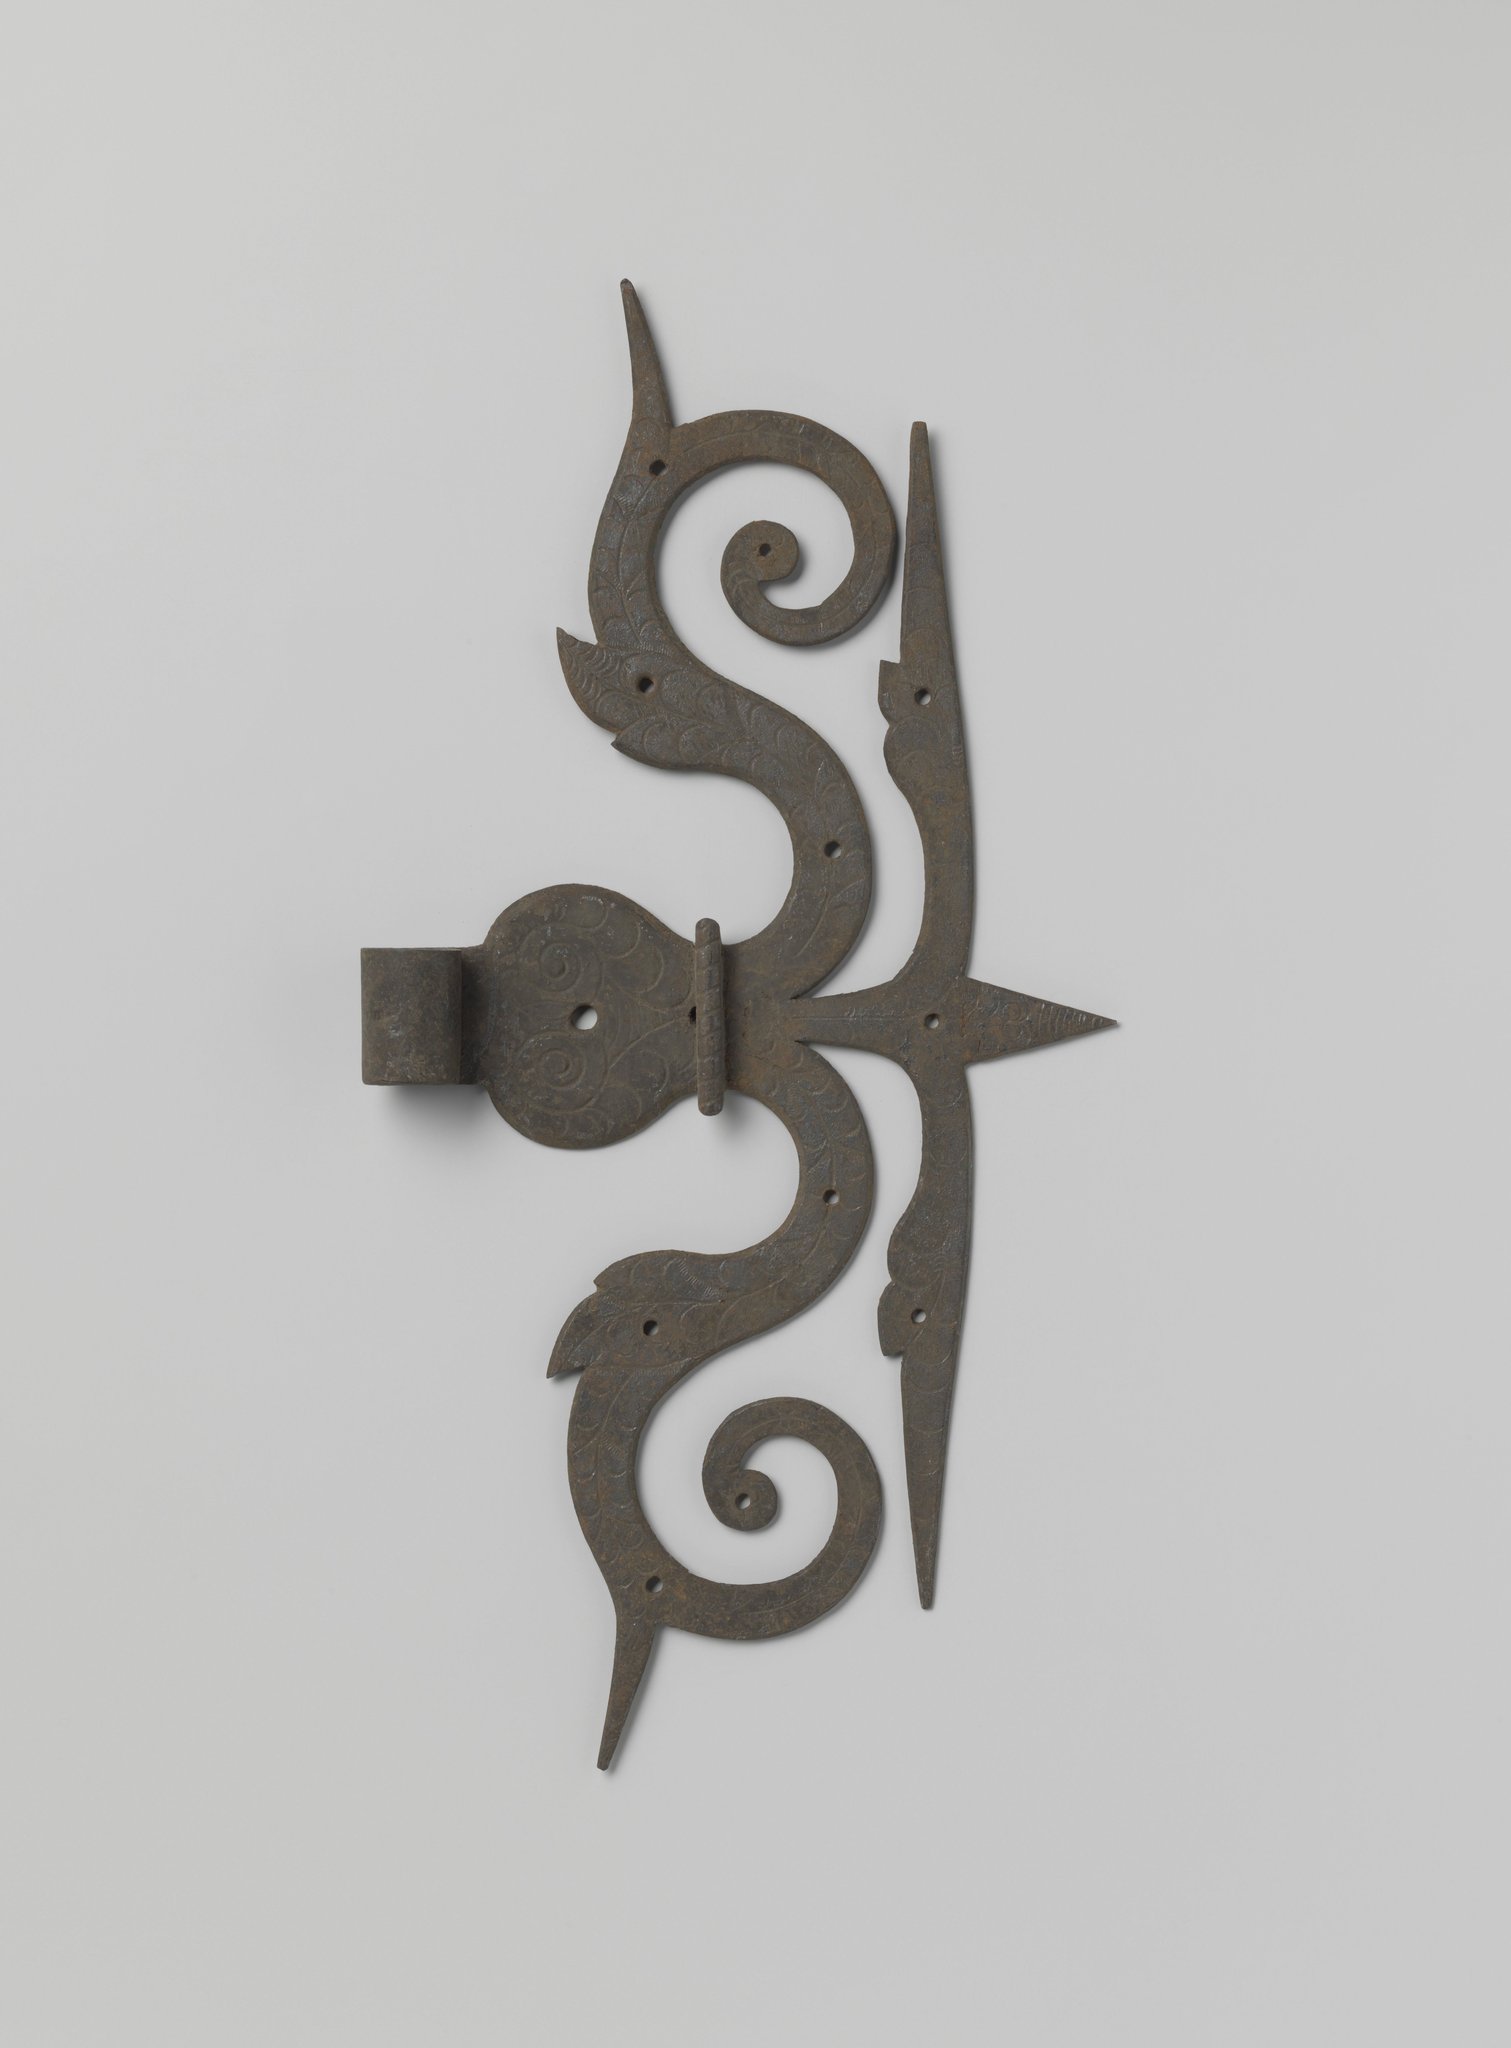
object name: deurhengsel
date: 1400-1950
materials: iron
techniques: forging